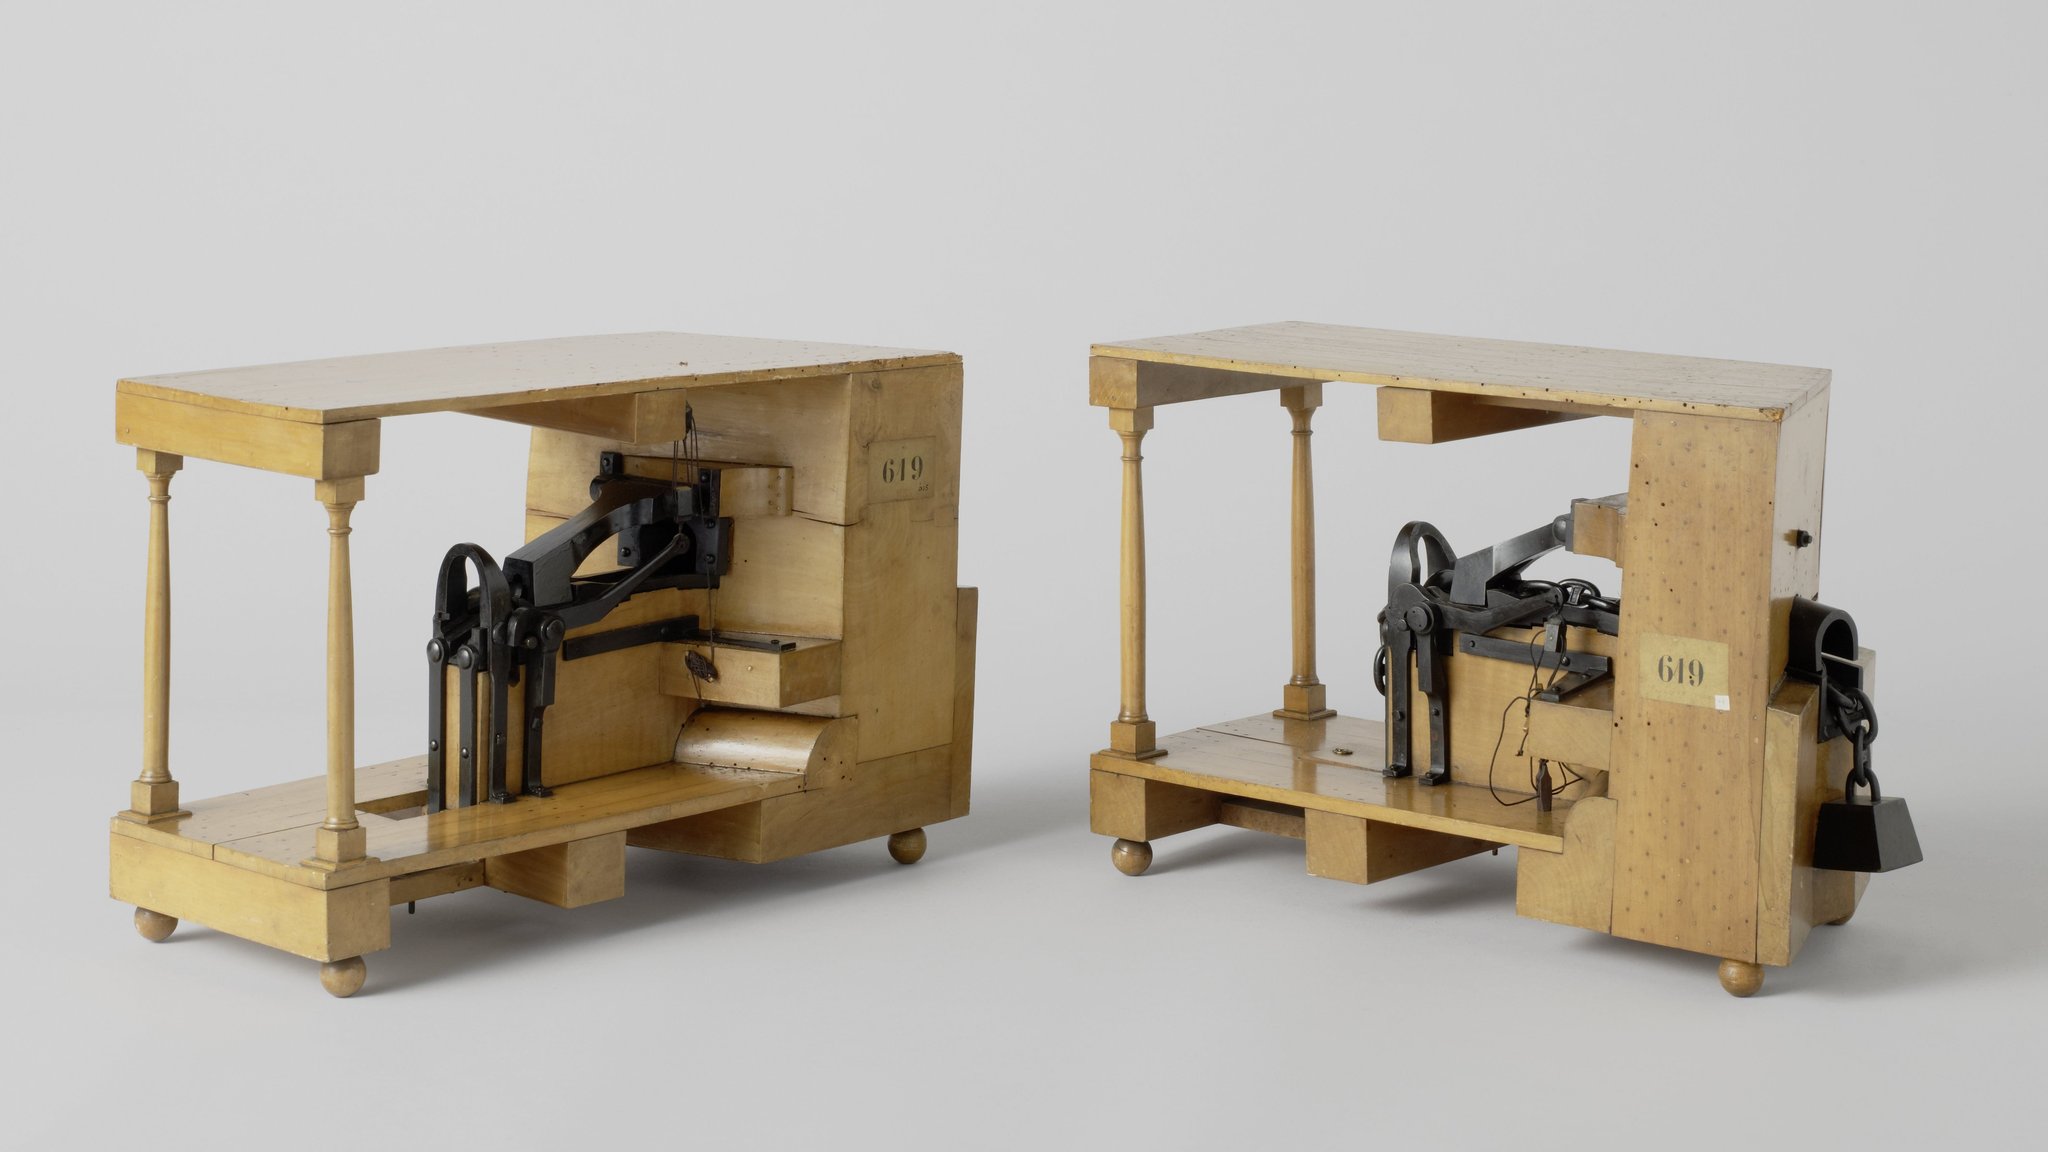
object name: demonstration model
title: Model of a Chain Stopper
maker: Anonymous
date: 1833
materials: fiber, wood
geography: france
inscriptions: label, centre right: ‘619’ former inventory label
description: Model van een kettingstopper tussen twee dekken, bestaande uit een glijbaan voor de ketting op een klos en doorlopend door het bakboord kluisgat, en een zware duivelsklauw hangend aan een klos aan de scheepswand. Een houten ketting met namaakgewicht is aan het model toegevoegd. Schaal 1:10 (schatting).